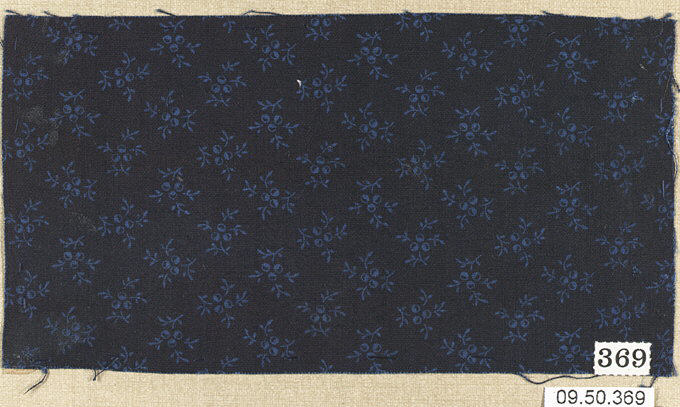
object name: piece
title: Piece (one of 116)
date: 1801-1900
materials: cotton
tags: leaves